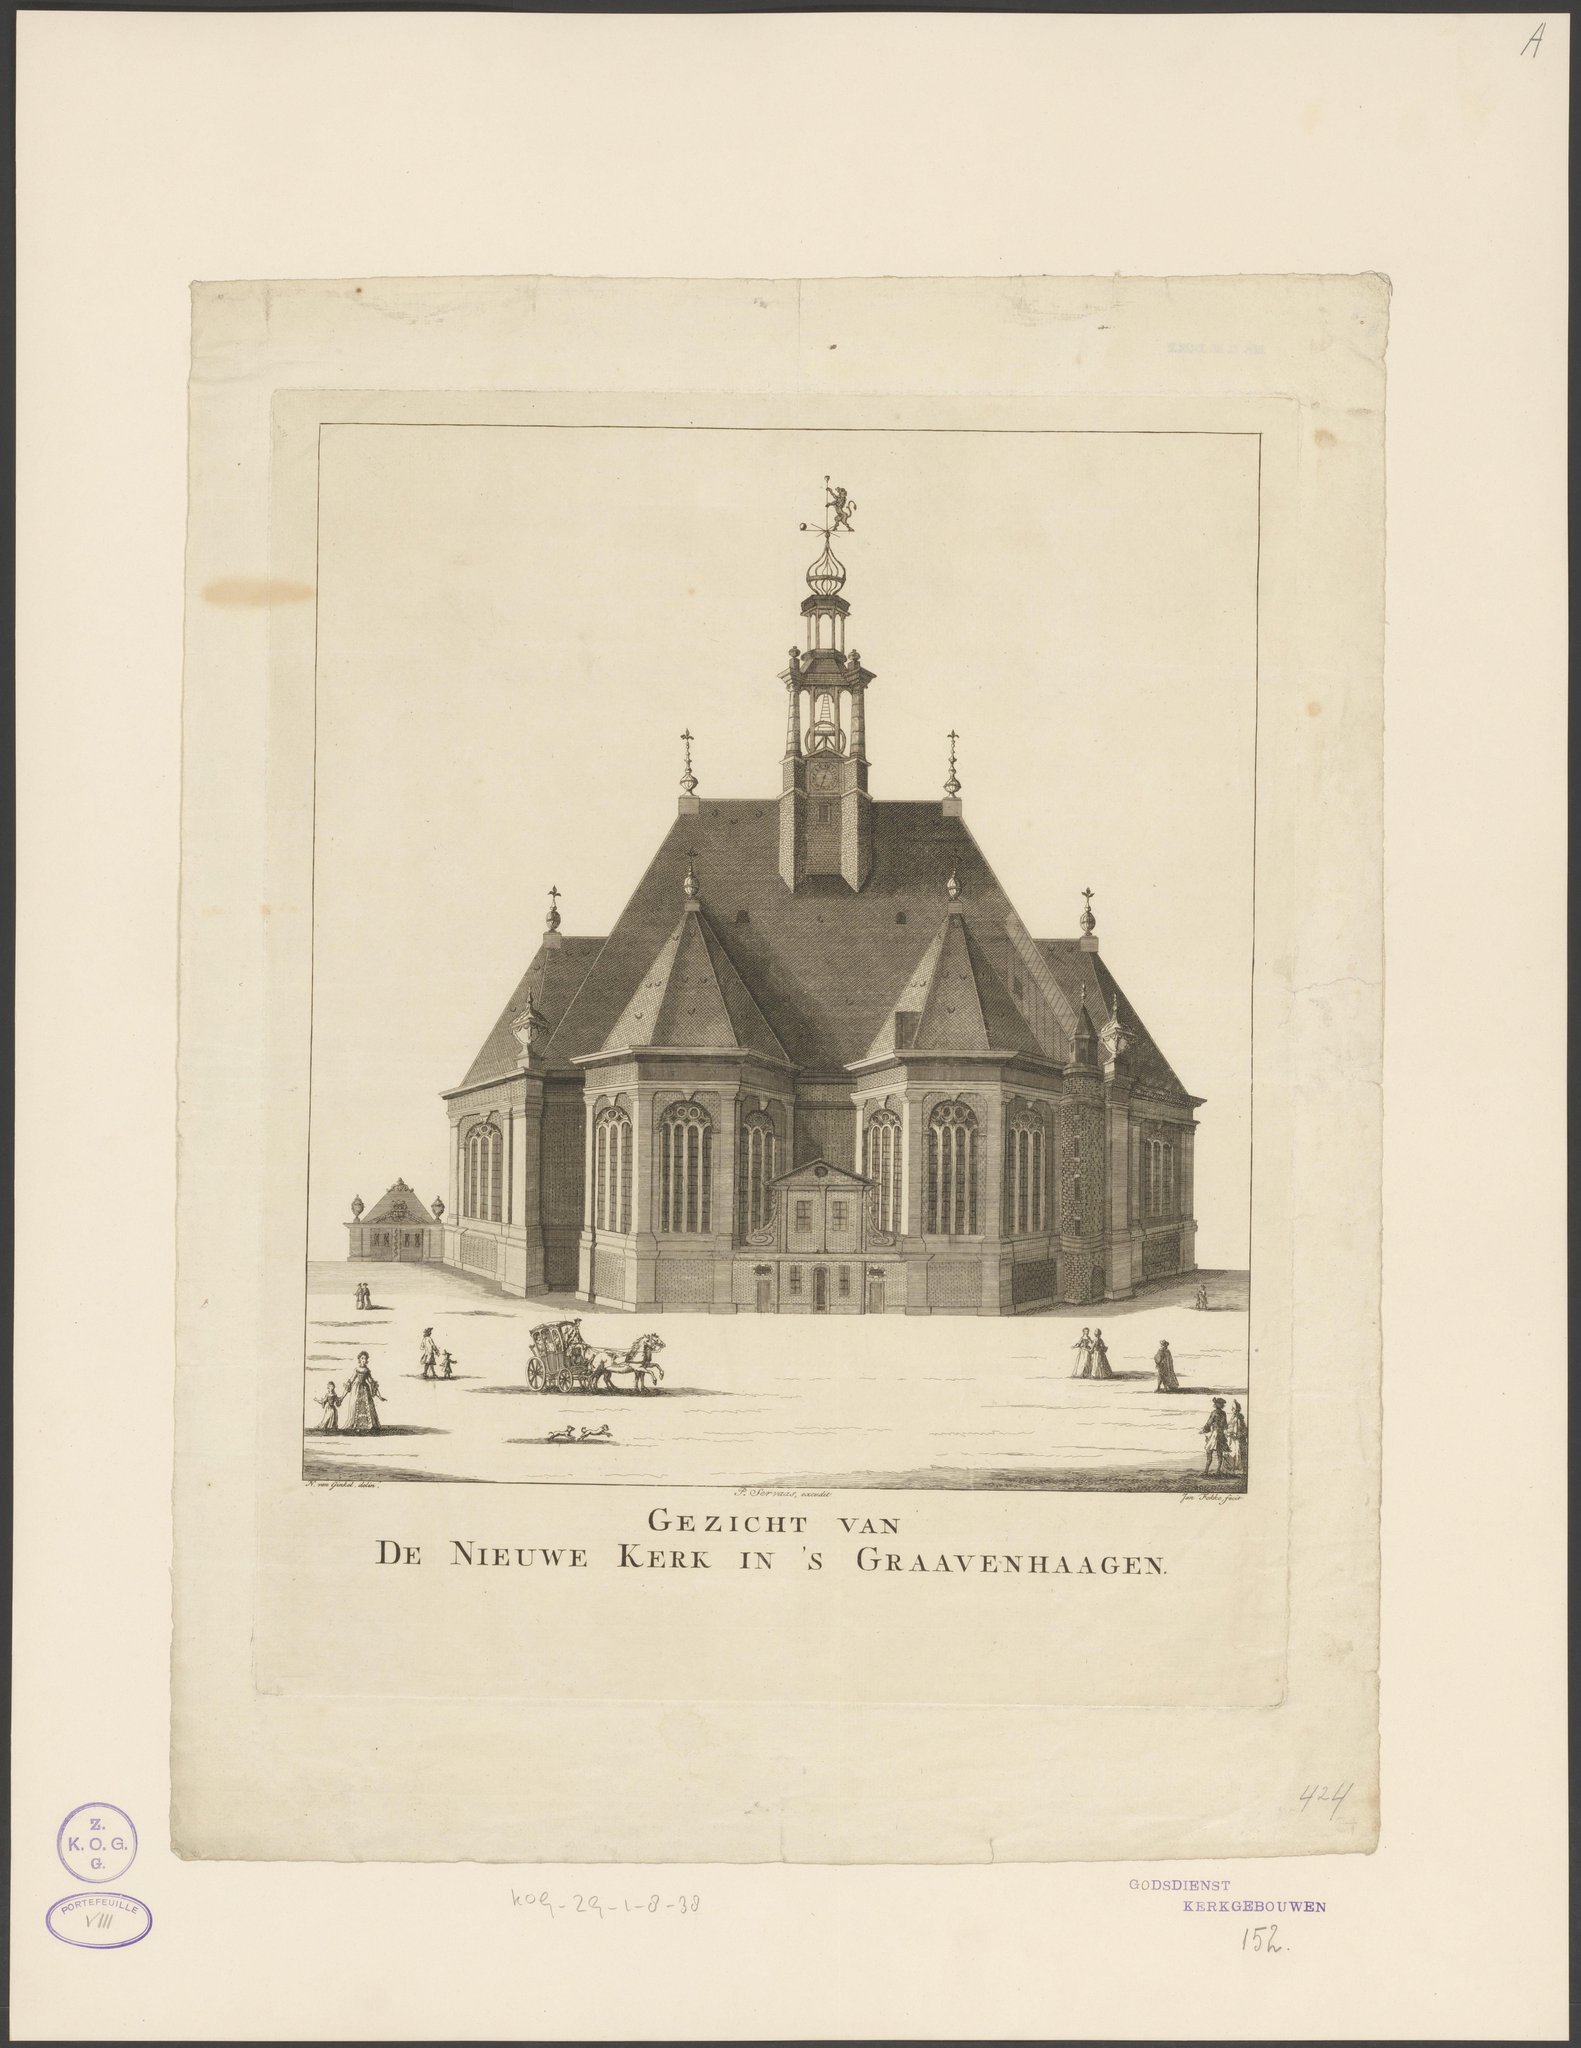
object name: print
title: Gezicht op de Nieuwe kerk te Den Haag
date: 1752-1781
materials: paper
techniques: engraving, etching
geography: the hague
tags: church (exterior)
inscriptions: collector's mark, collector's mark: Lugt 1641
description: Gezicht op de Nieuwe kerk aan het Spui te Den Haag. Op de voorgrond wandelaars en een koets. Onderwerpsrubrieken binnen de Atlas Zeden en Gewoonten: Kerk en kerkwezen & Armwezen en liefdadige instellingen; Kerkgebouwen elders. F-L.